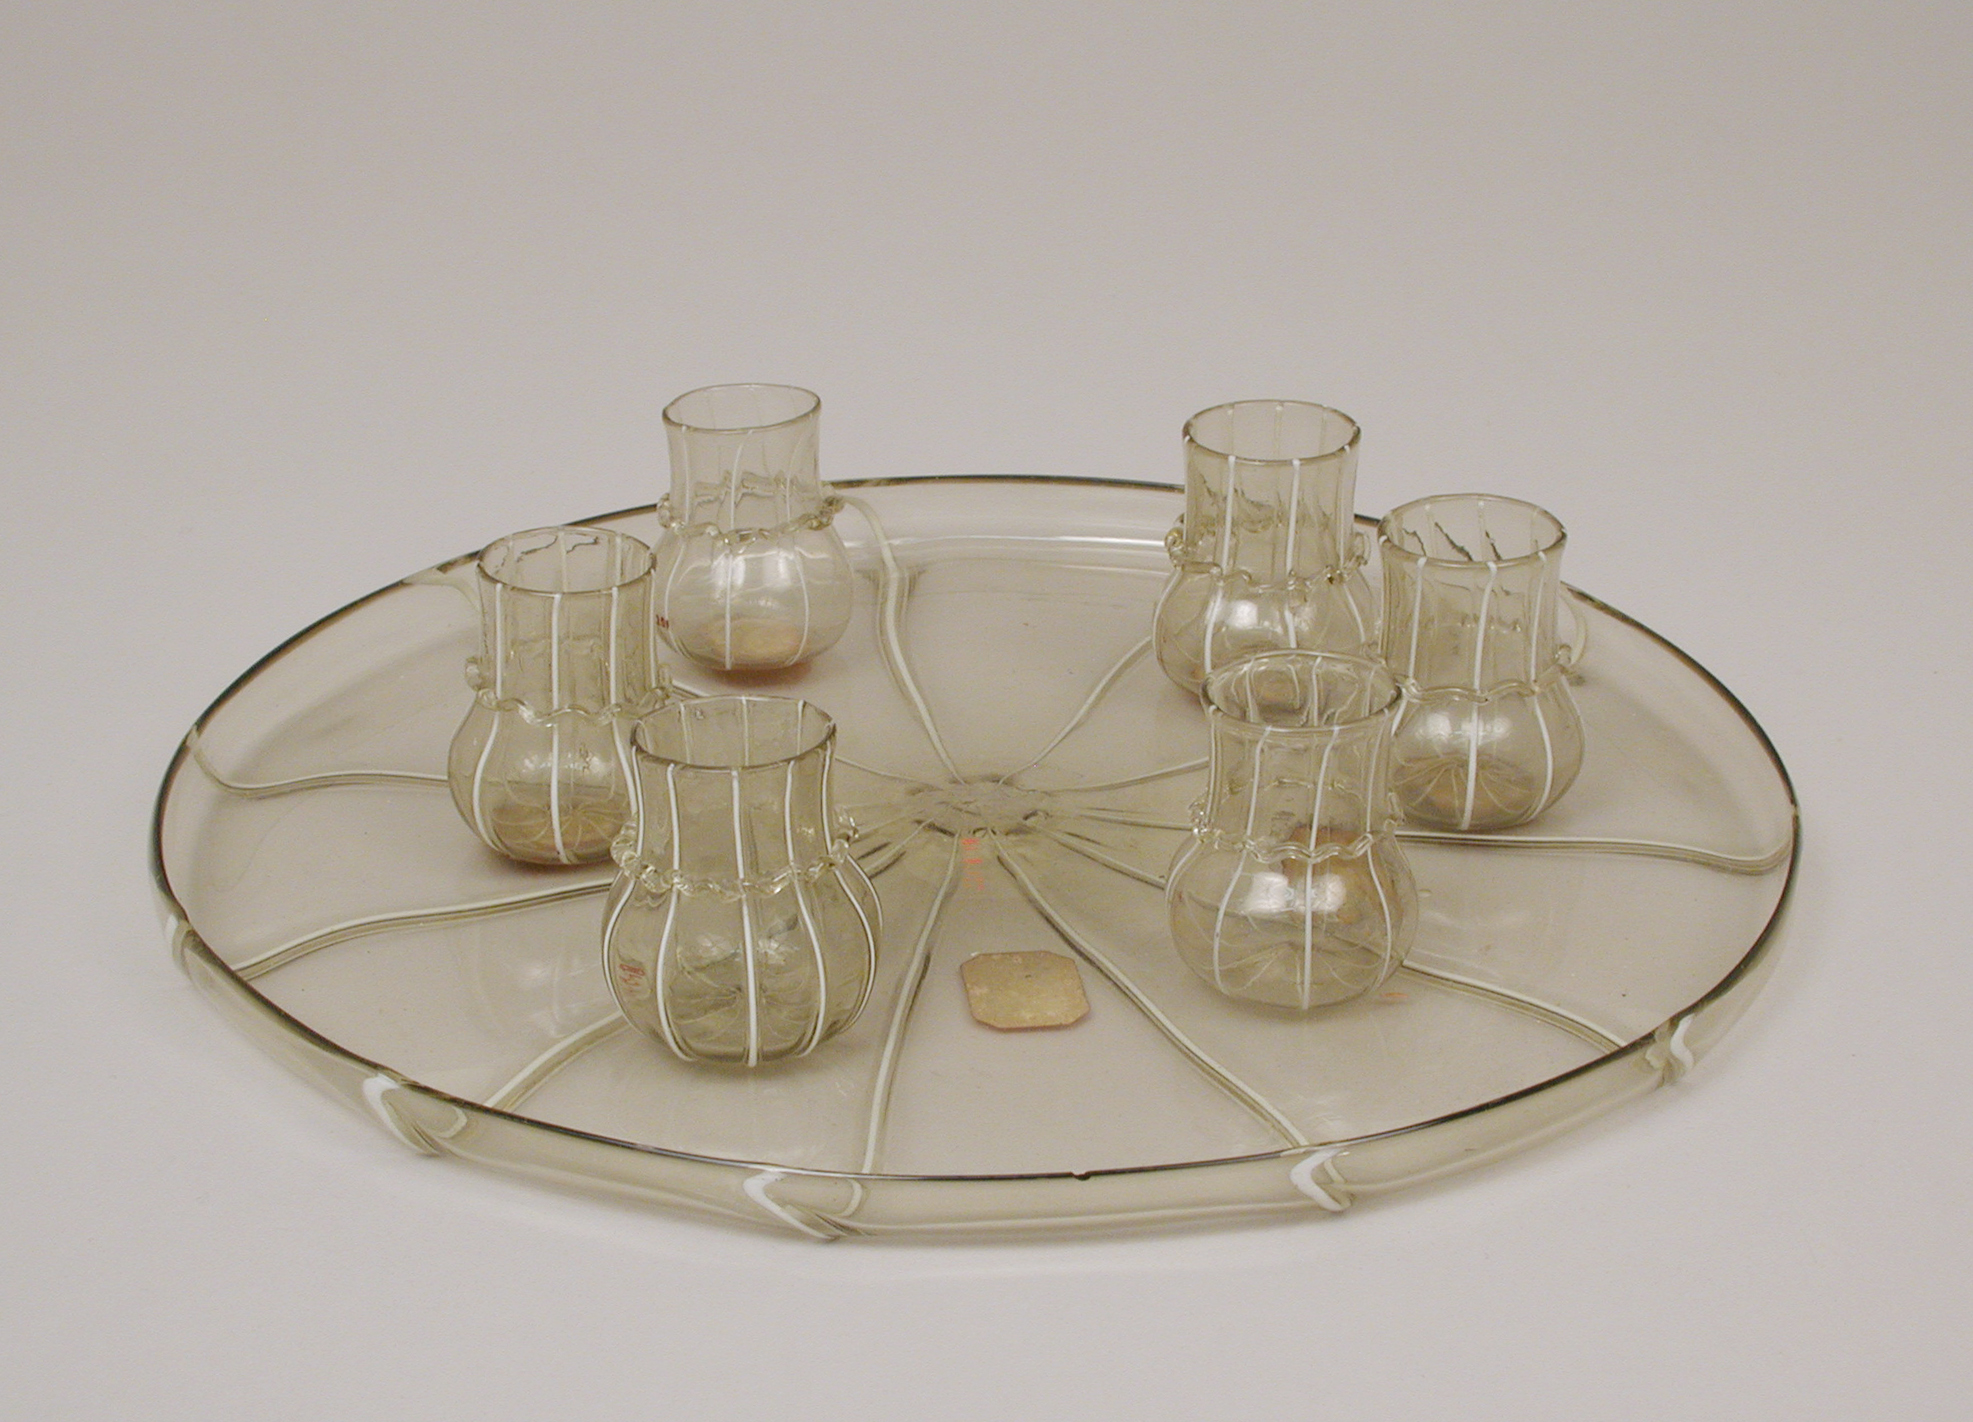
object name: schnapps glass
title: Schnapps glass (one of six)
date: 1801-1900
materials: glass